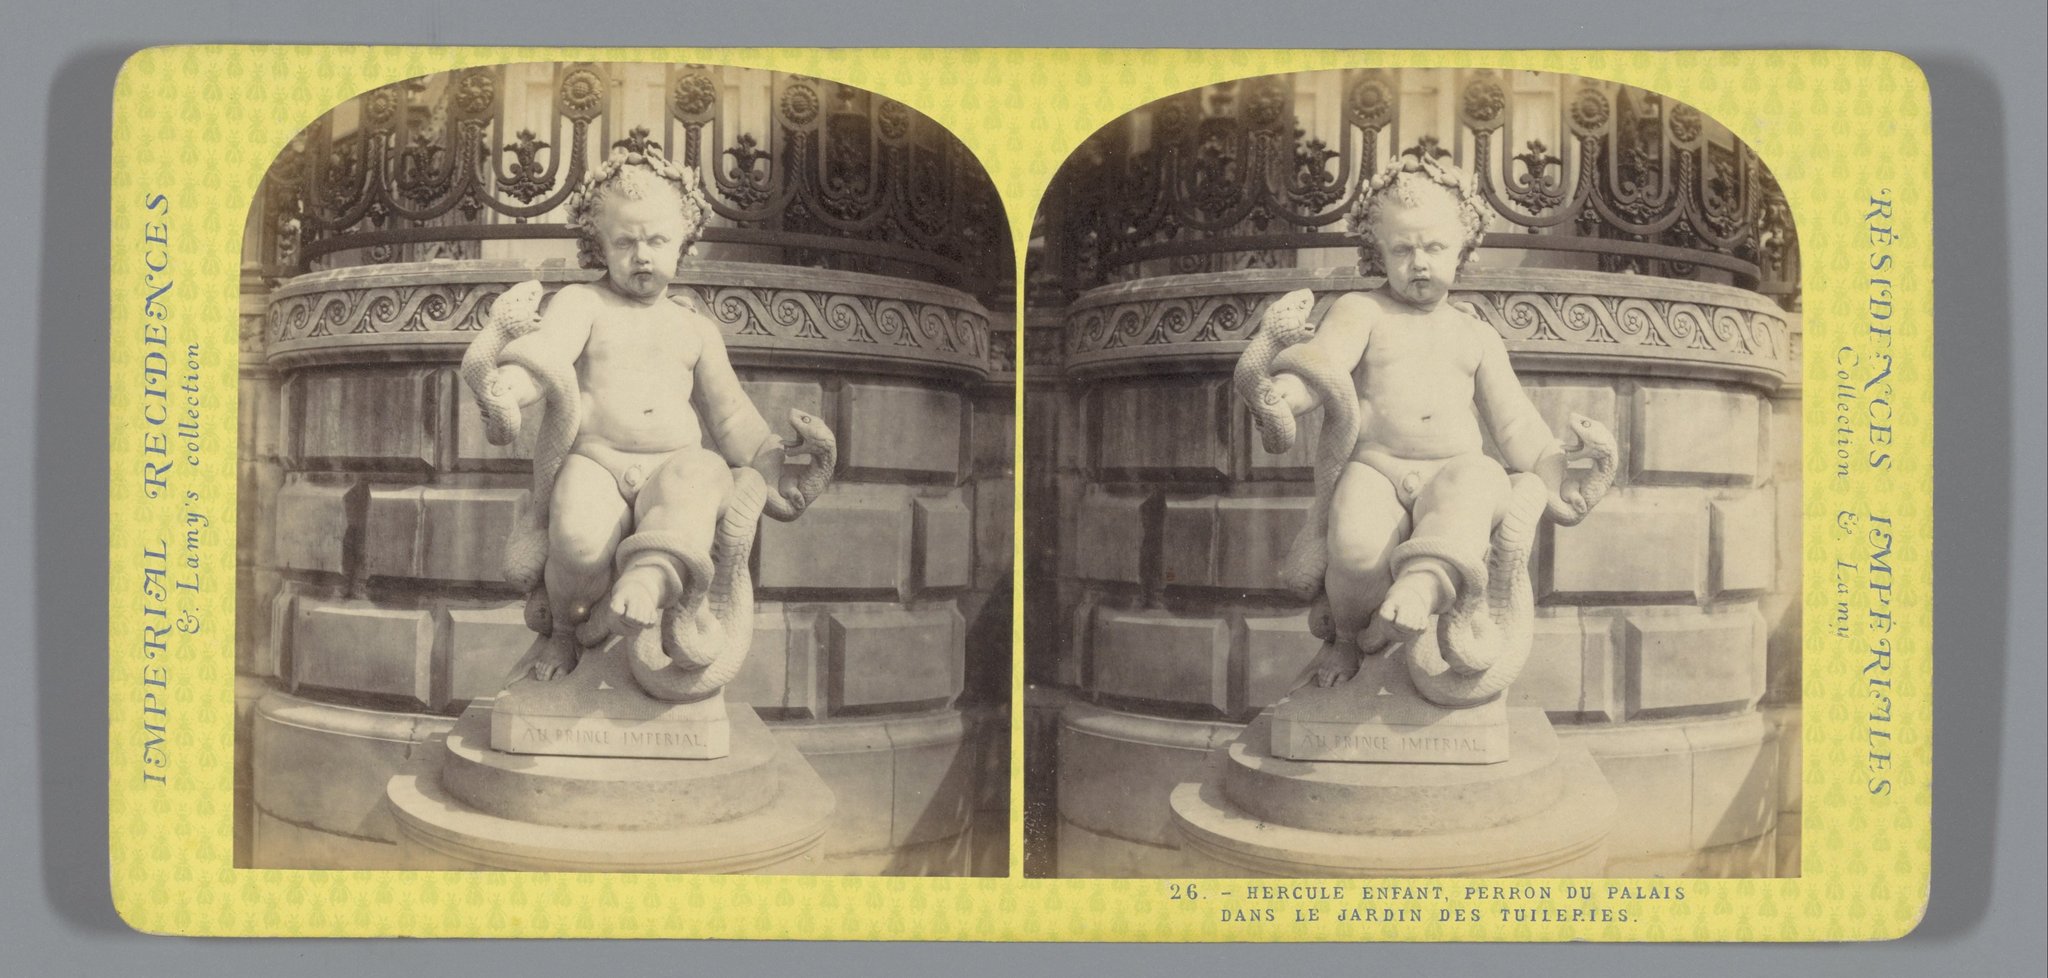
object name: stereograph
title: Sculptuur in de Jardin des Tuileries te Parijs, voorstellende Hercules worstelt met slangen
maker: ernest eléonor pierre lamy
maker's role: publisher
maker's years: 1828-1900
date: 1860-1871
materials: cardboard, photographic support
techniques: albumen print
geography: jardin des tuileries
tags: hercules strangles two serpents in his cradle, sculpture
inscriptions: number: ‘26.’, inscription: ‘E. Lamy's collection’